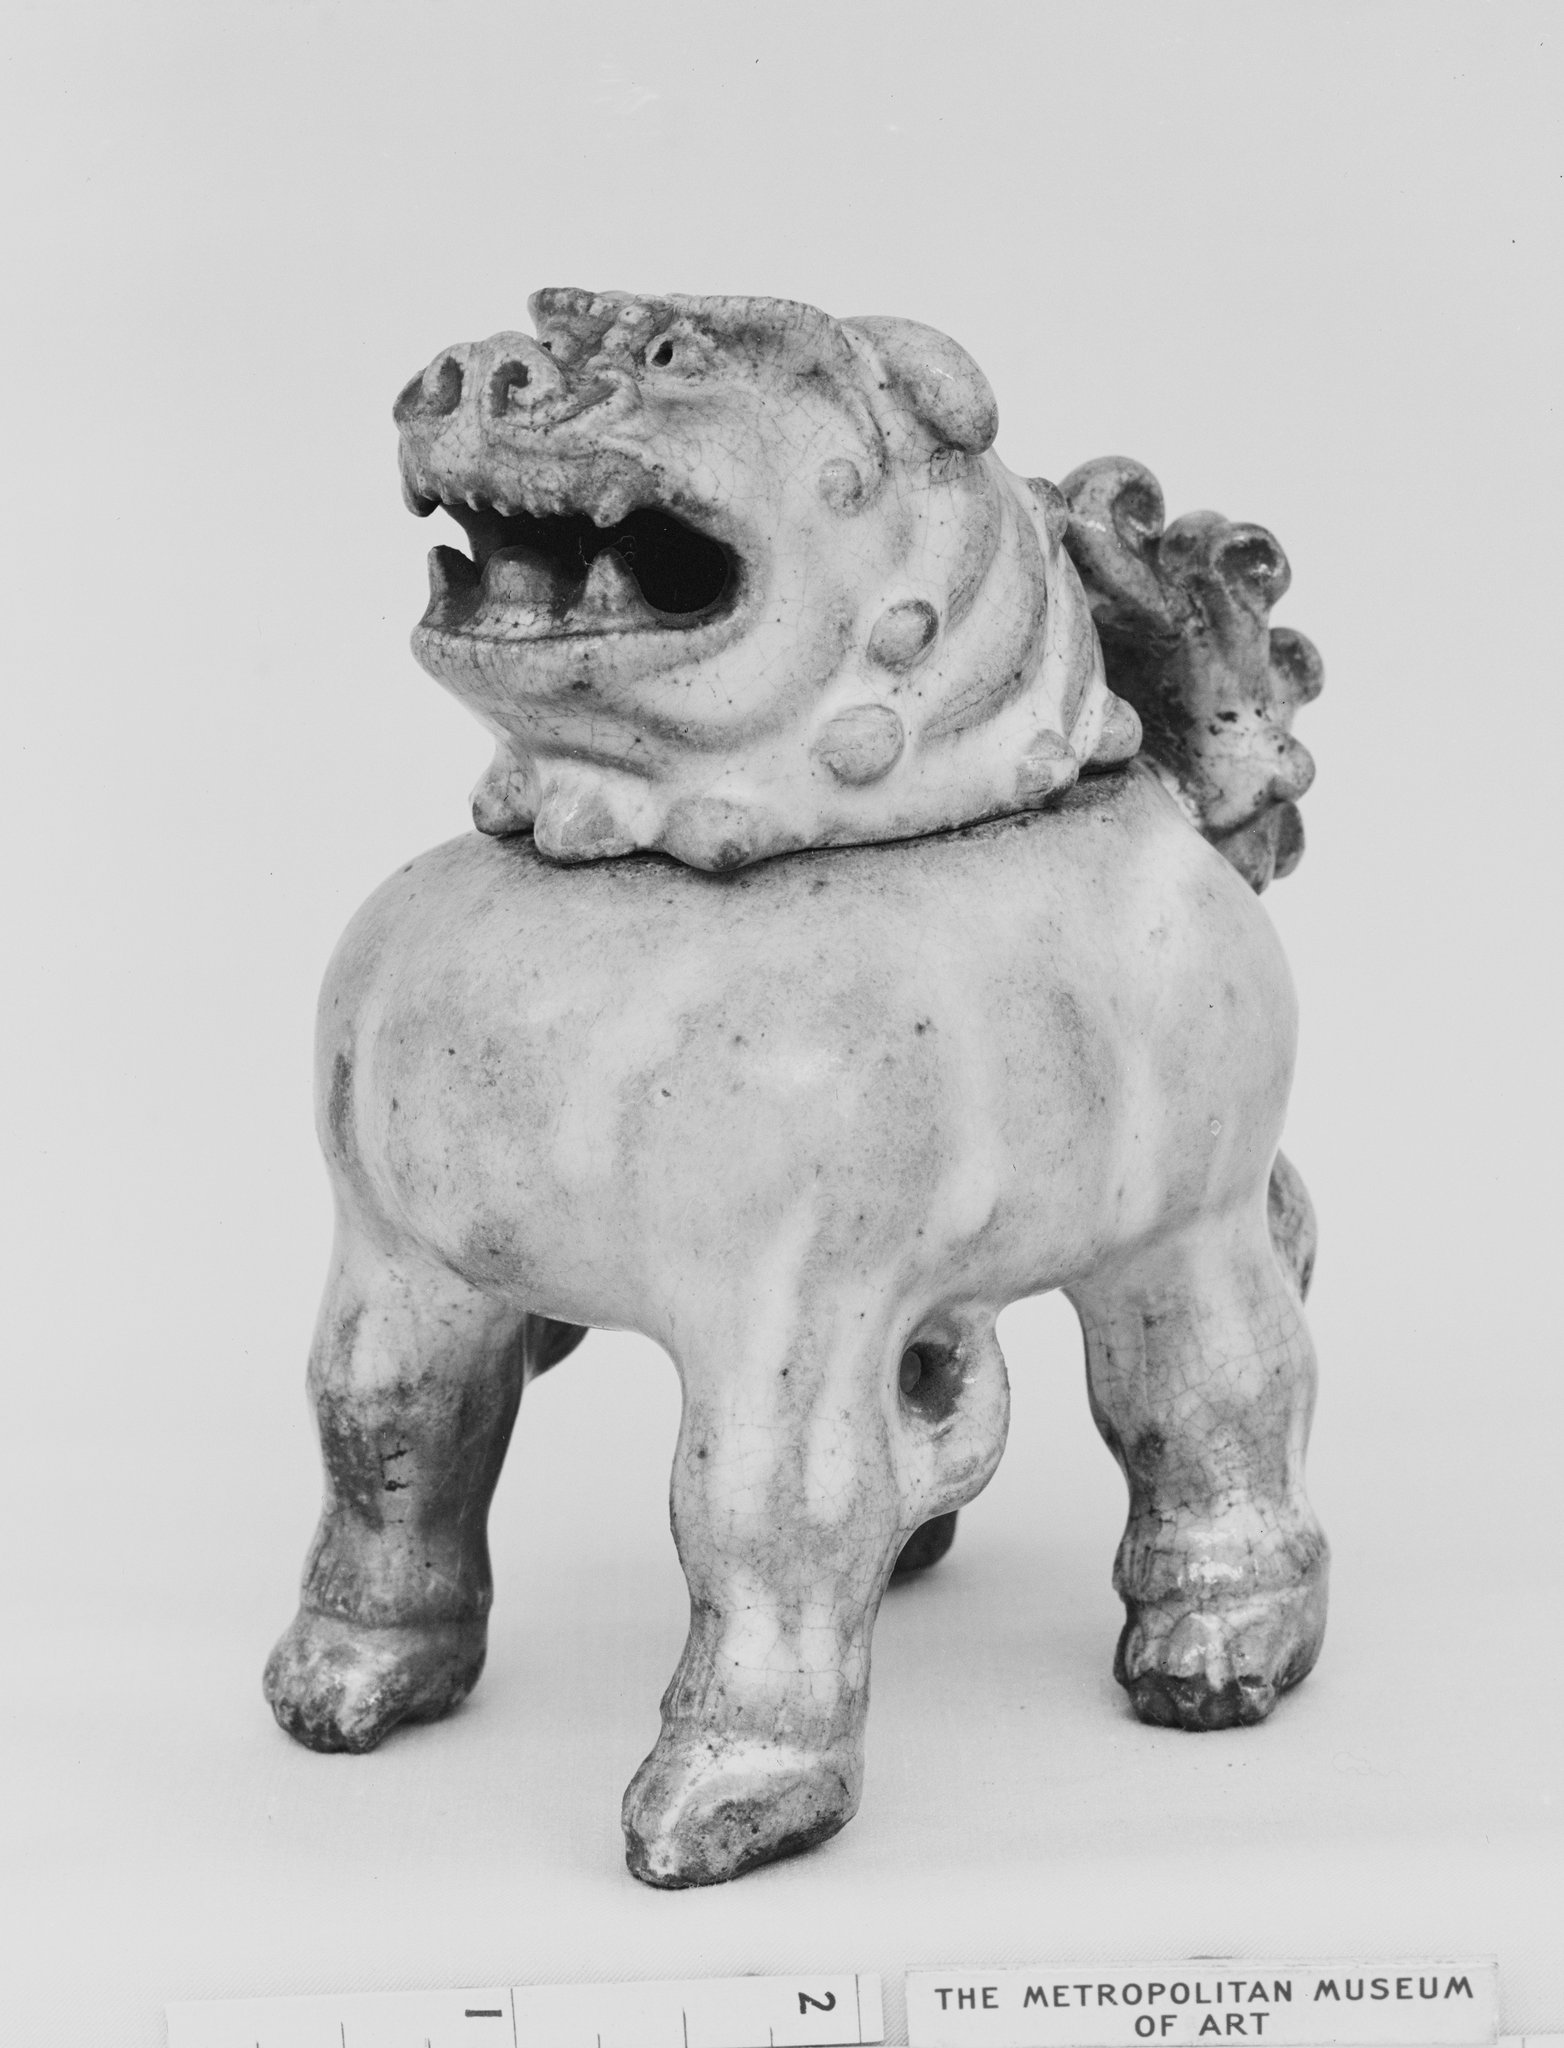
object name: incense burner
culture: japanese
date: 1801-1900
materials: clay, glaze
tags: lions